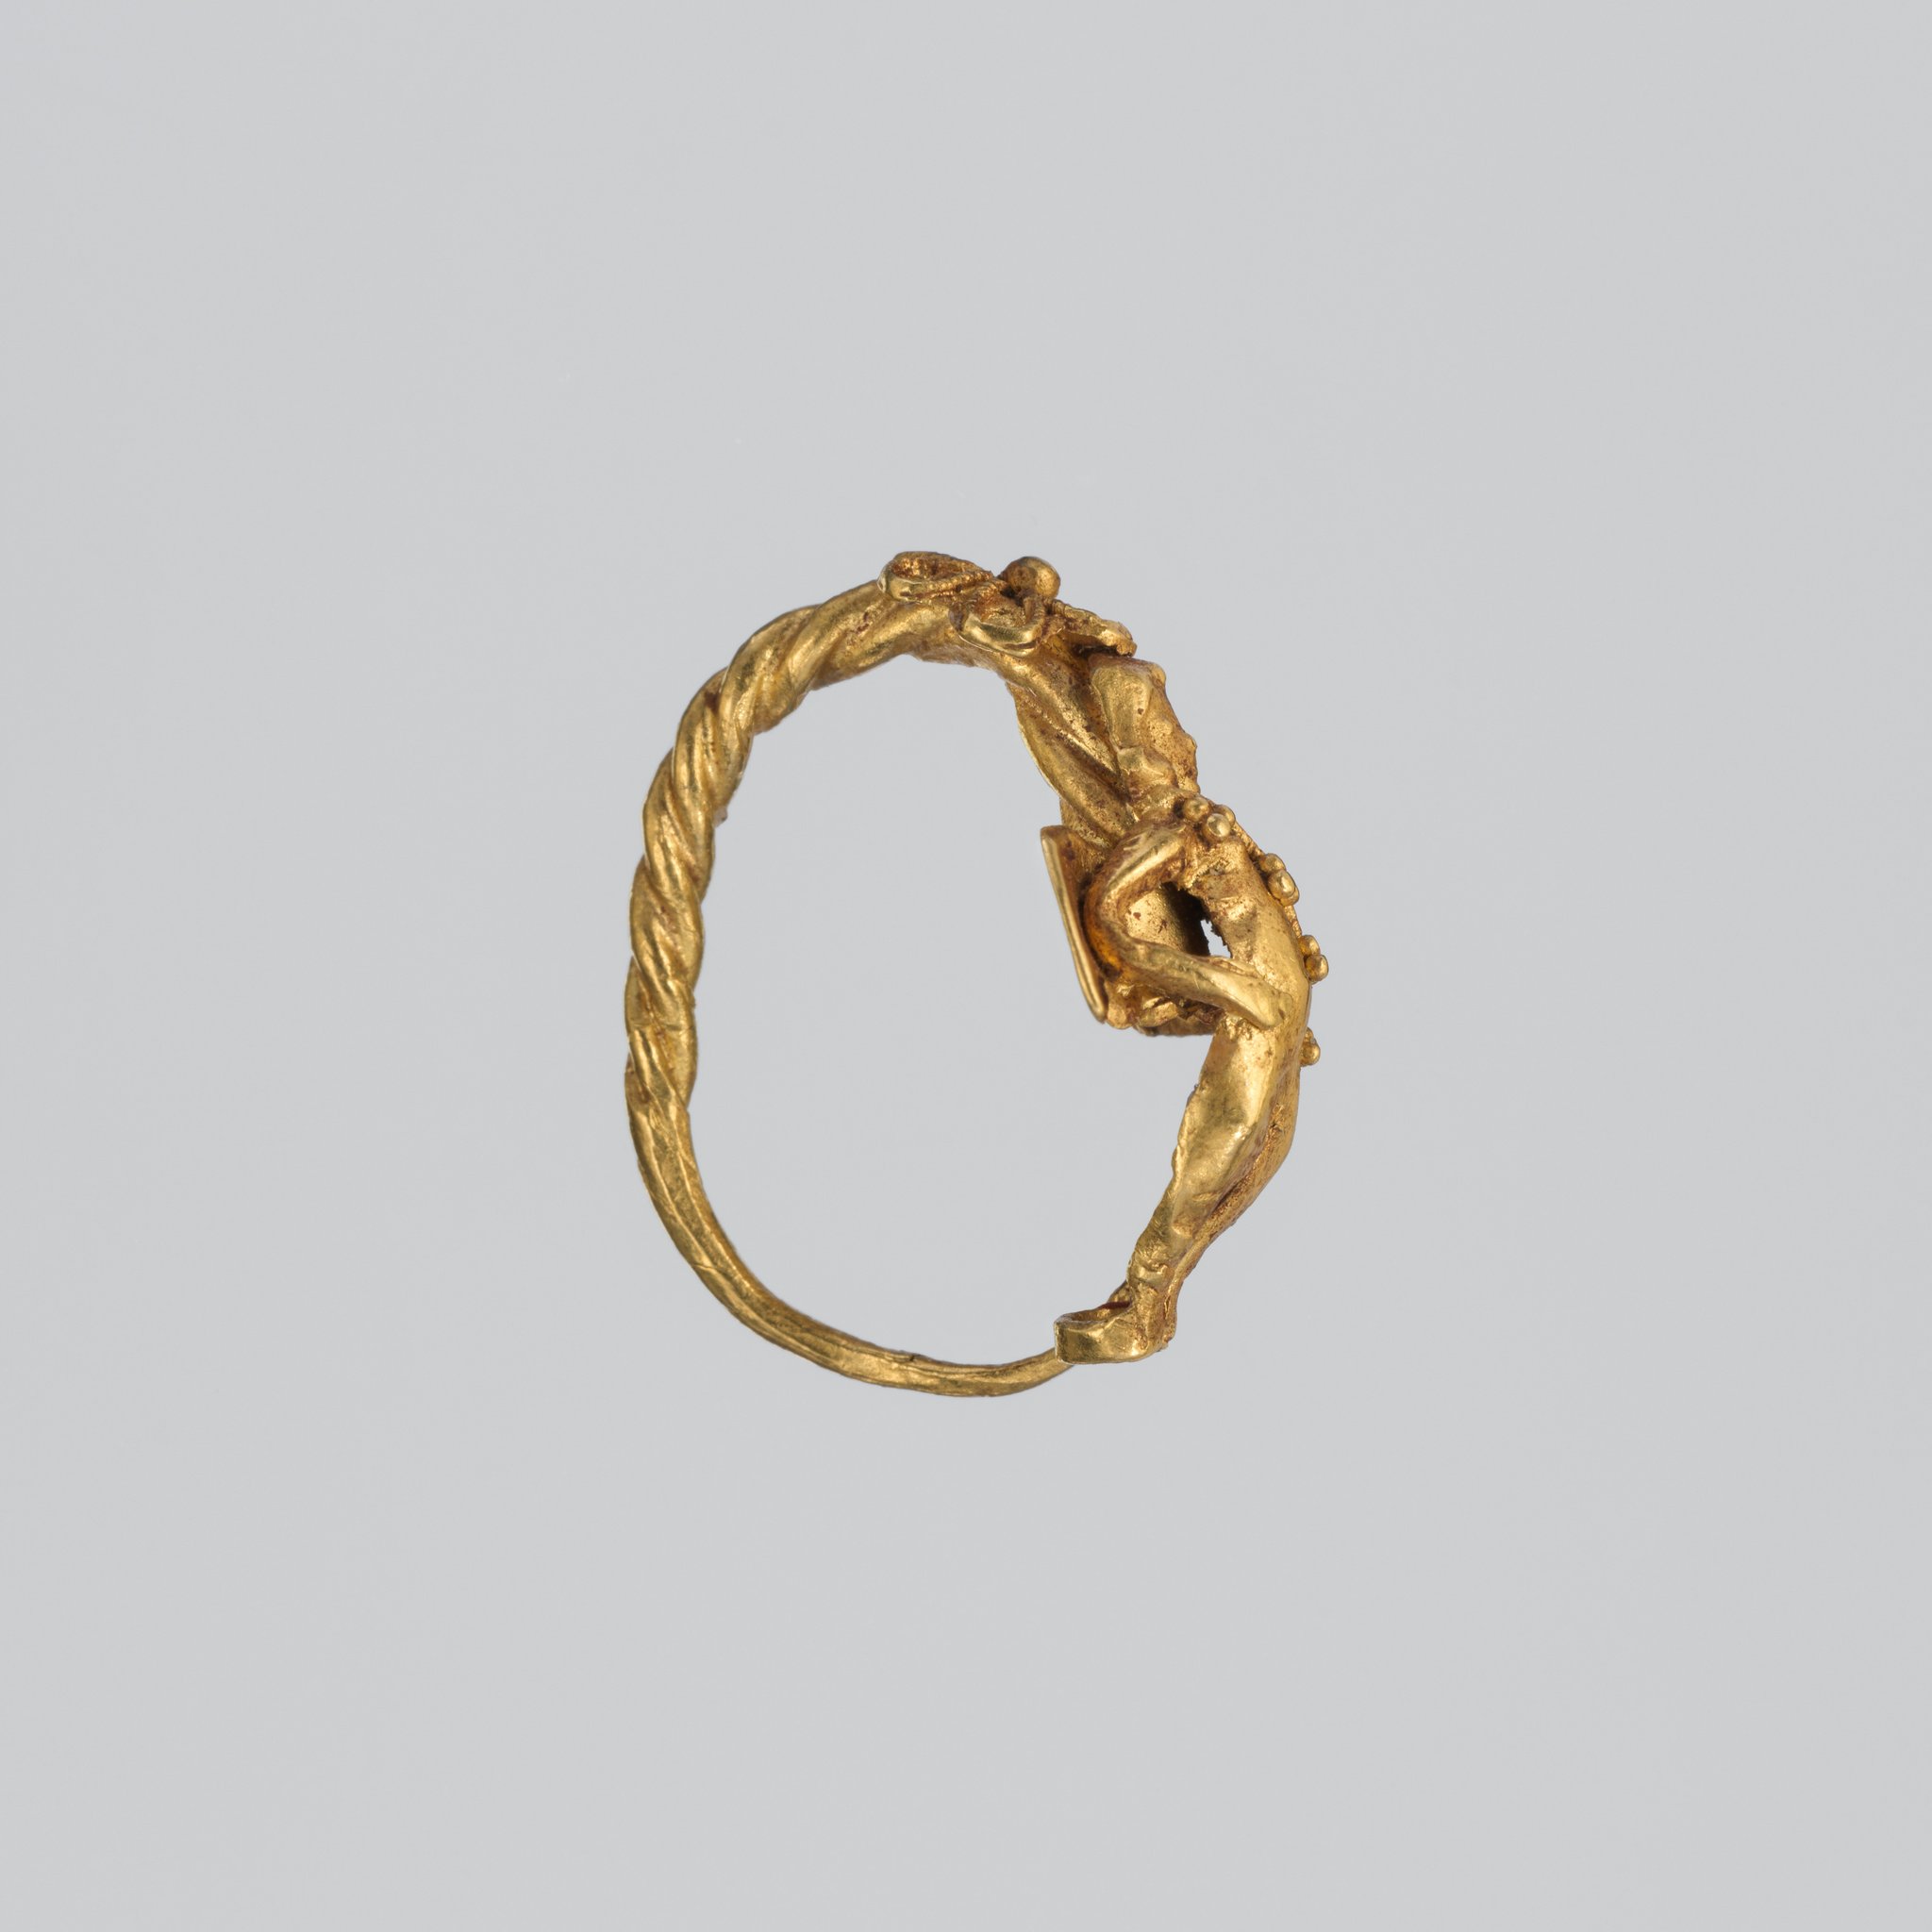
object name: earring with human figure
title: Gold earring with winged figure (one of a pair)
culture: greek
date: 100-1 BCE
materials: gold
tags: animals,eros